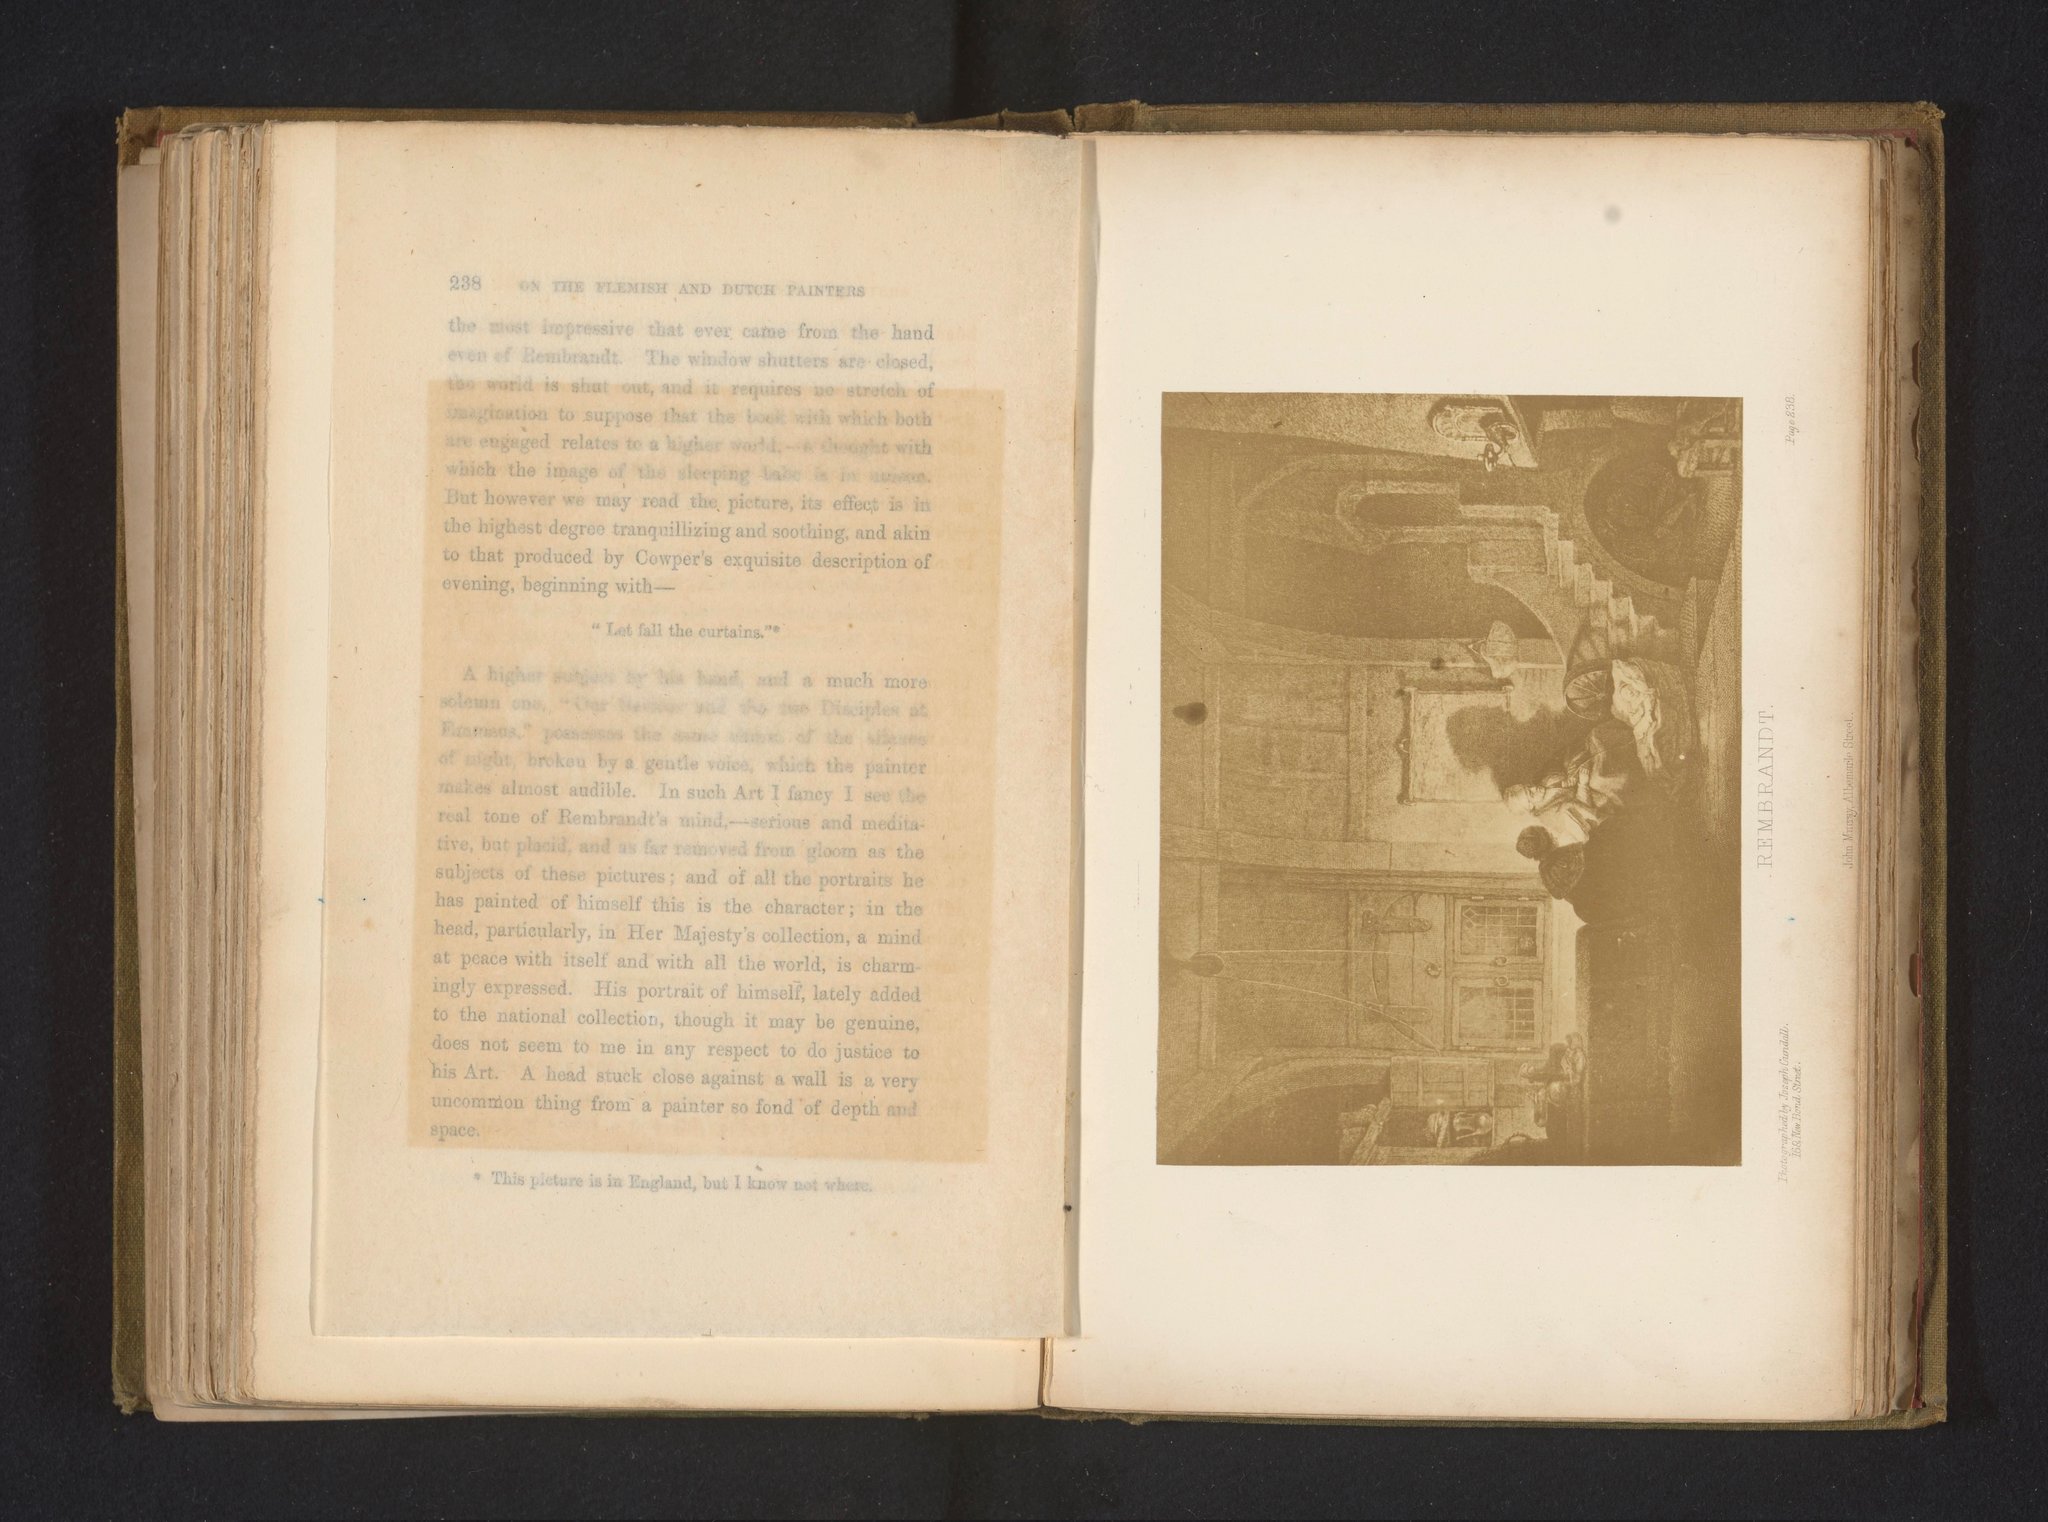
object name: page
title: Rembrandt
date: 1850-1855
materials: photographic support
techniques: albumen print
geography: london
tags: spinning-wheel, cradle, crib, interior ~ representation of a building, spinning (manufacture of yarn)